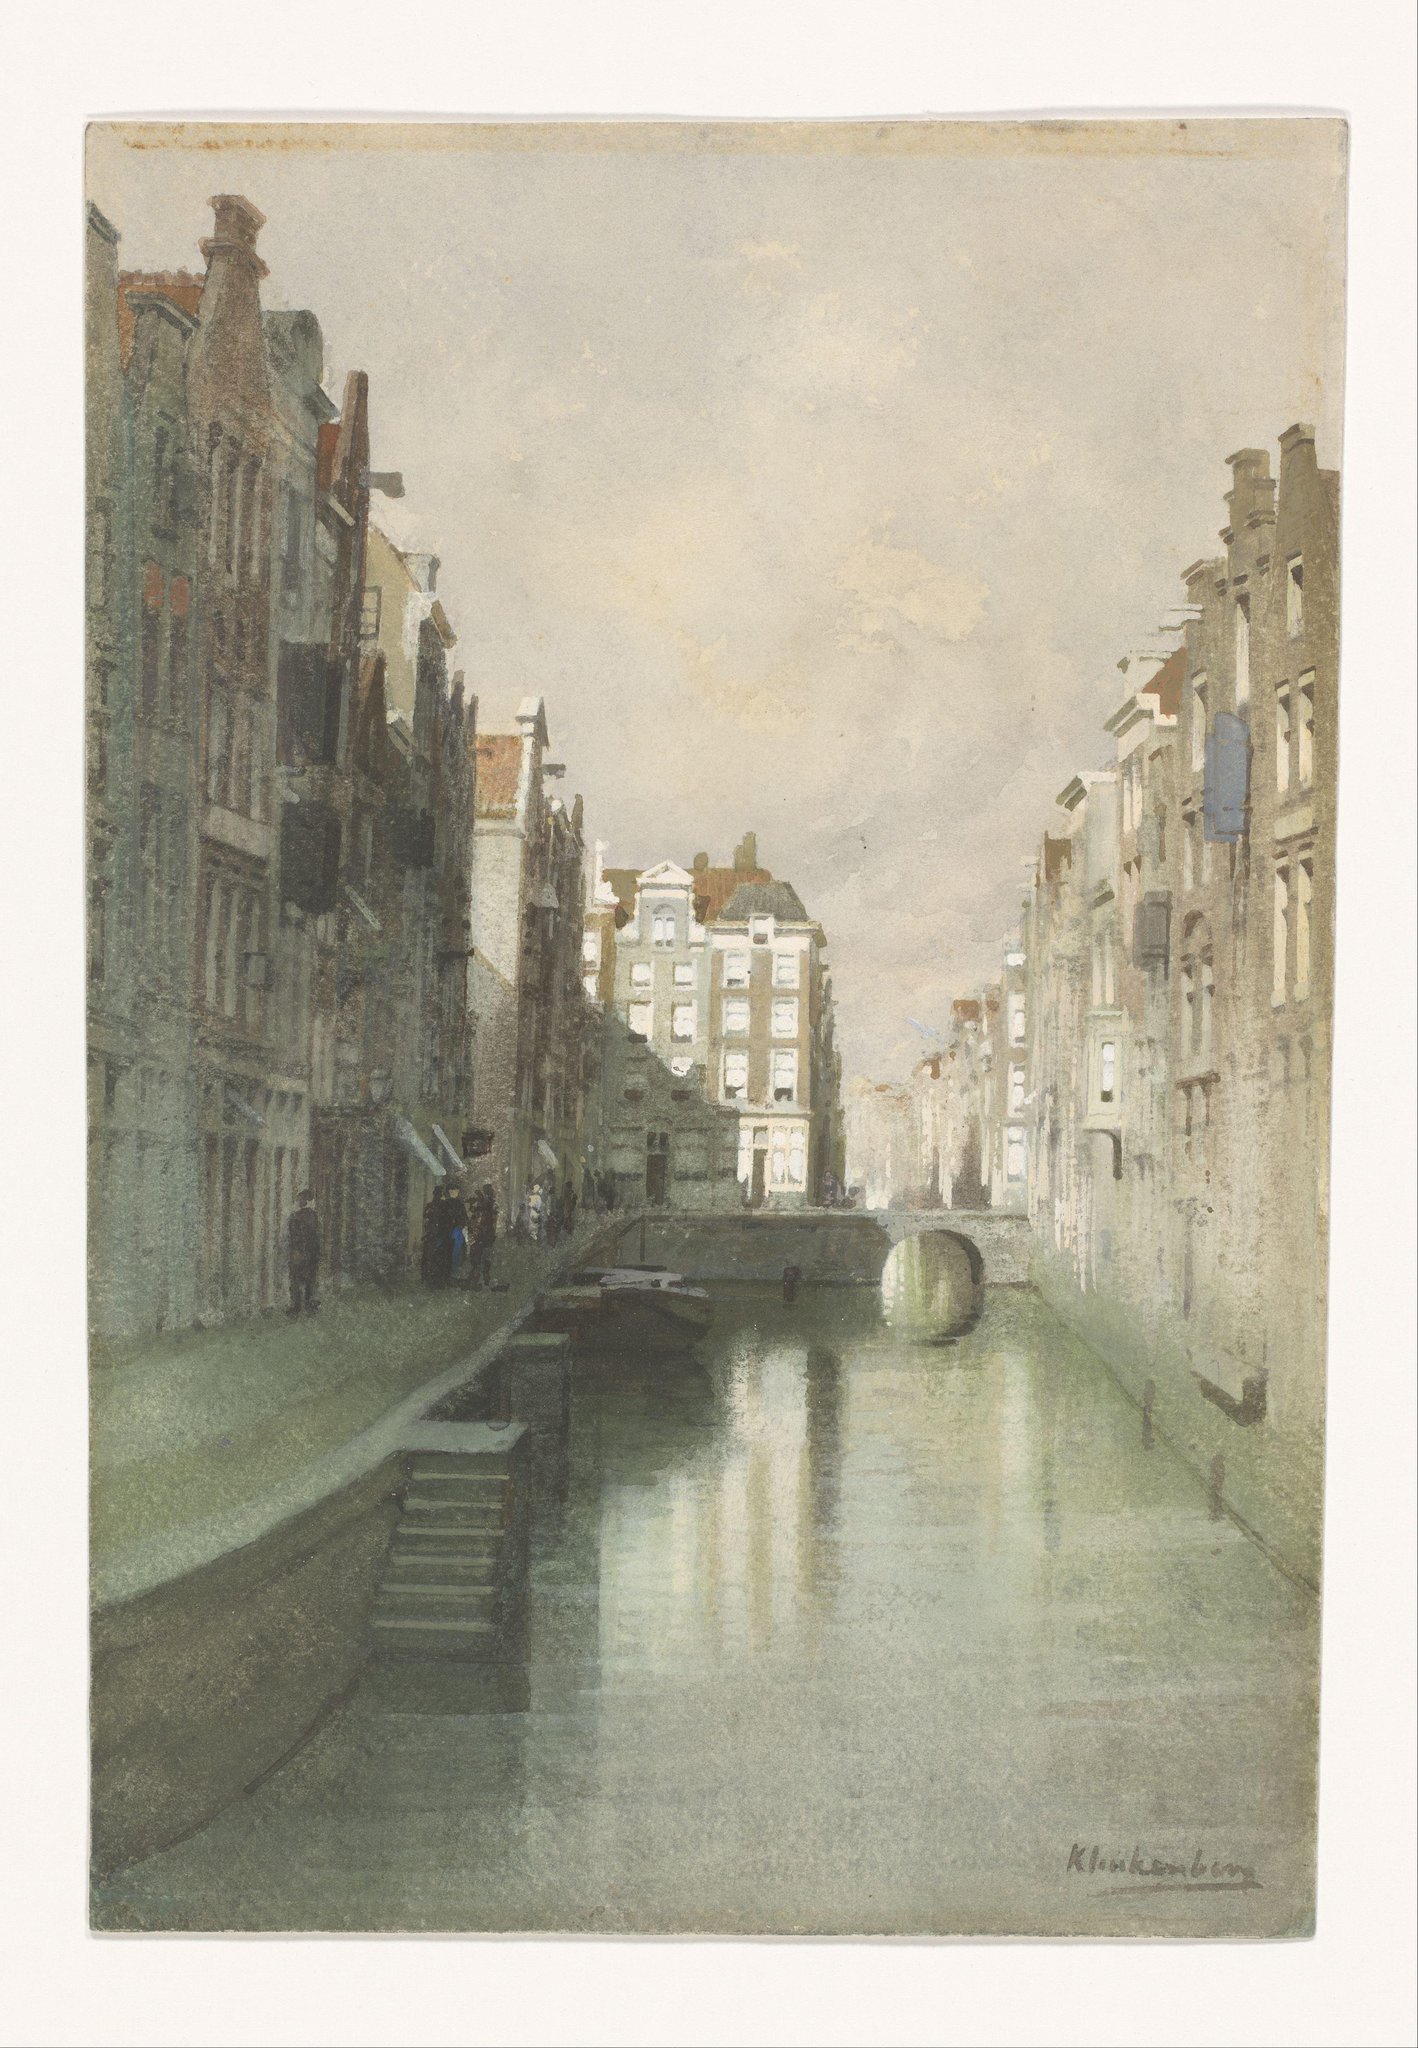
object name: drawing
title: Rotterdam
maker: johannes christiaan karel klinkenberg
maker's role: draughtsman, painter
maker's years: 1852-1924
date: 1875-1899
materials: paper, watercolor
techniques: brush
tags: rotterdam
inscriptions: signature: ‘Klinkenberg’, title: ‘R'dam’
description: Gezicht op een gracht, met links de kade en grachtenpanden, in de verte een brug.